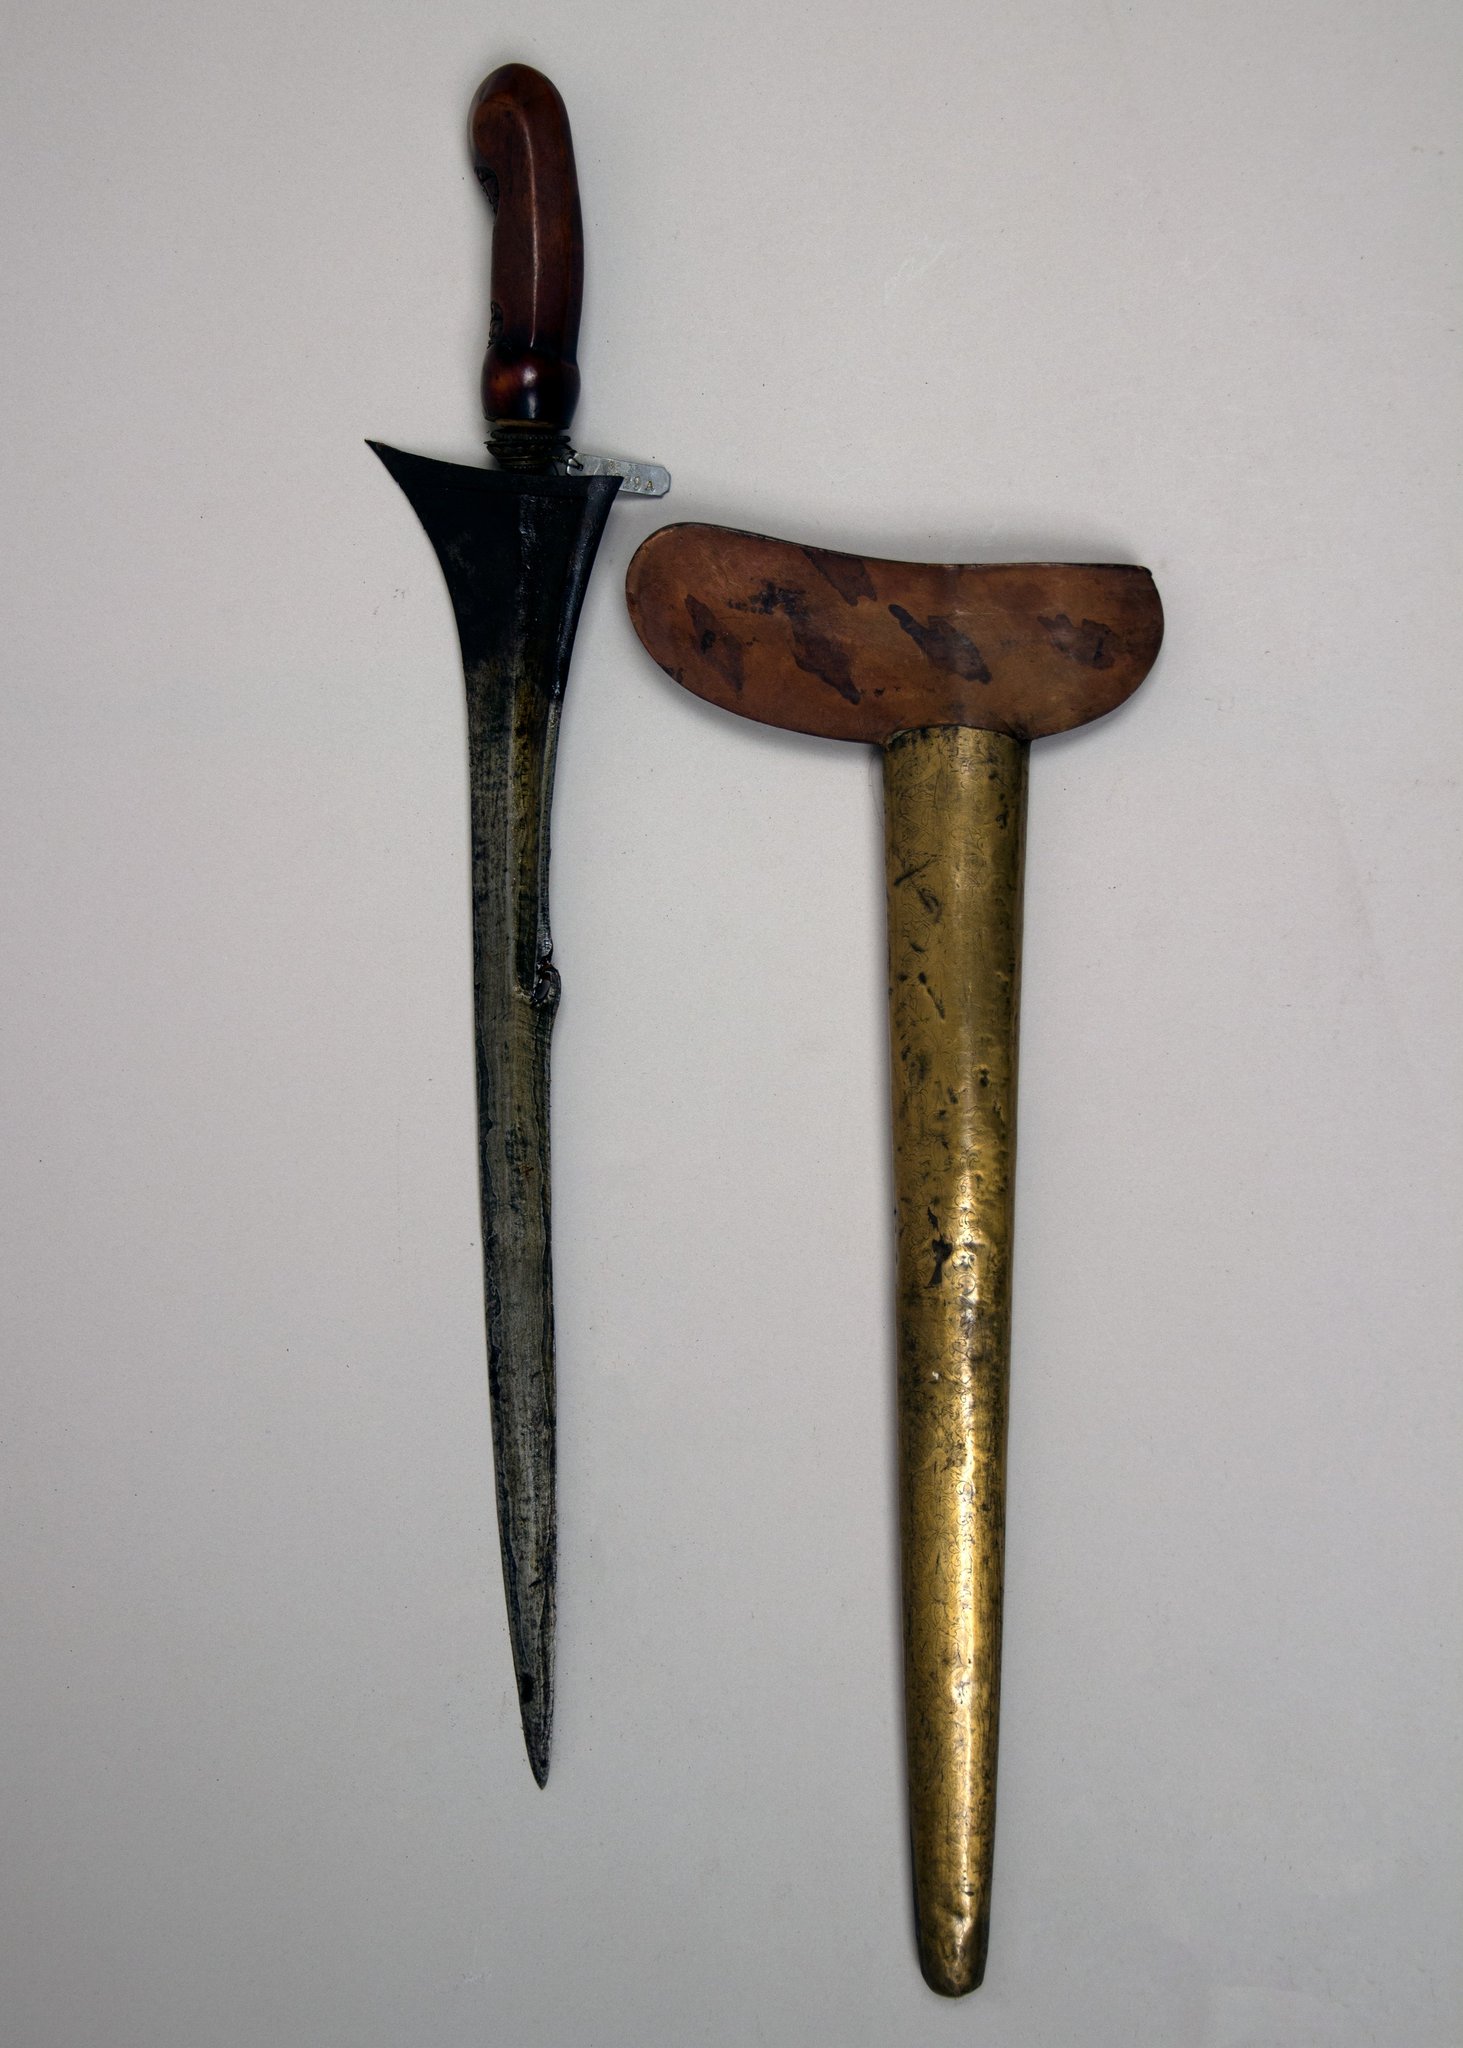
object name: kris with sheath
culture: javanese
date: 1501-1900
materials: brass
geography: indonesia